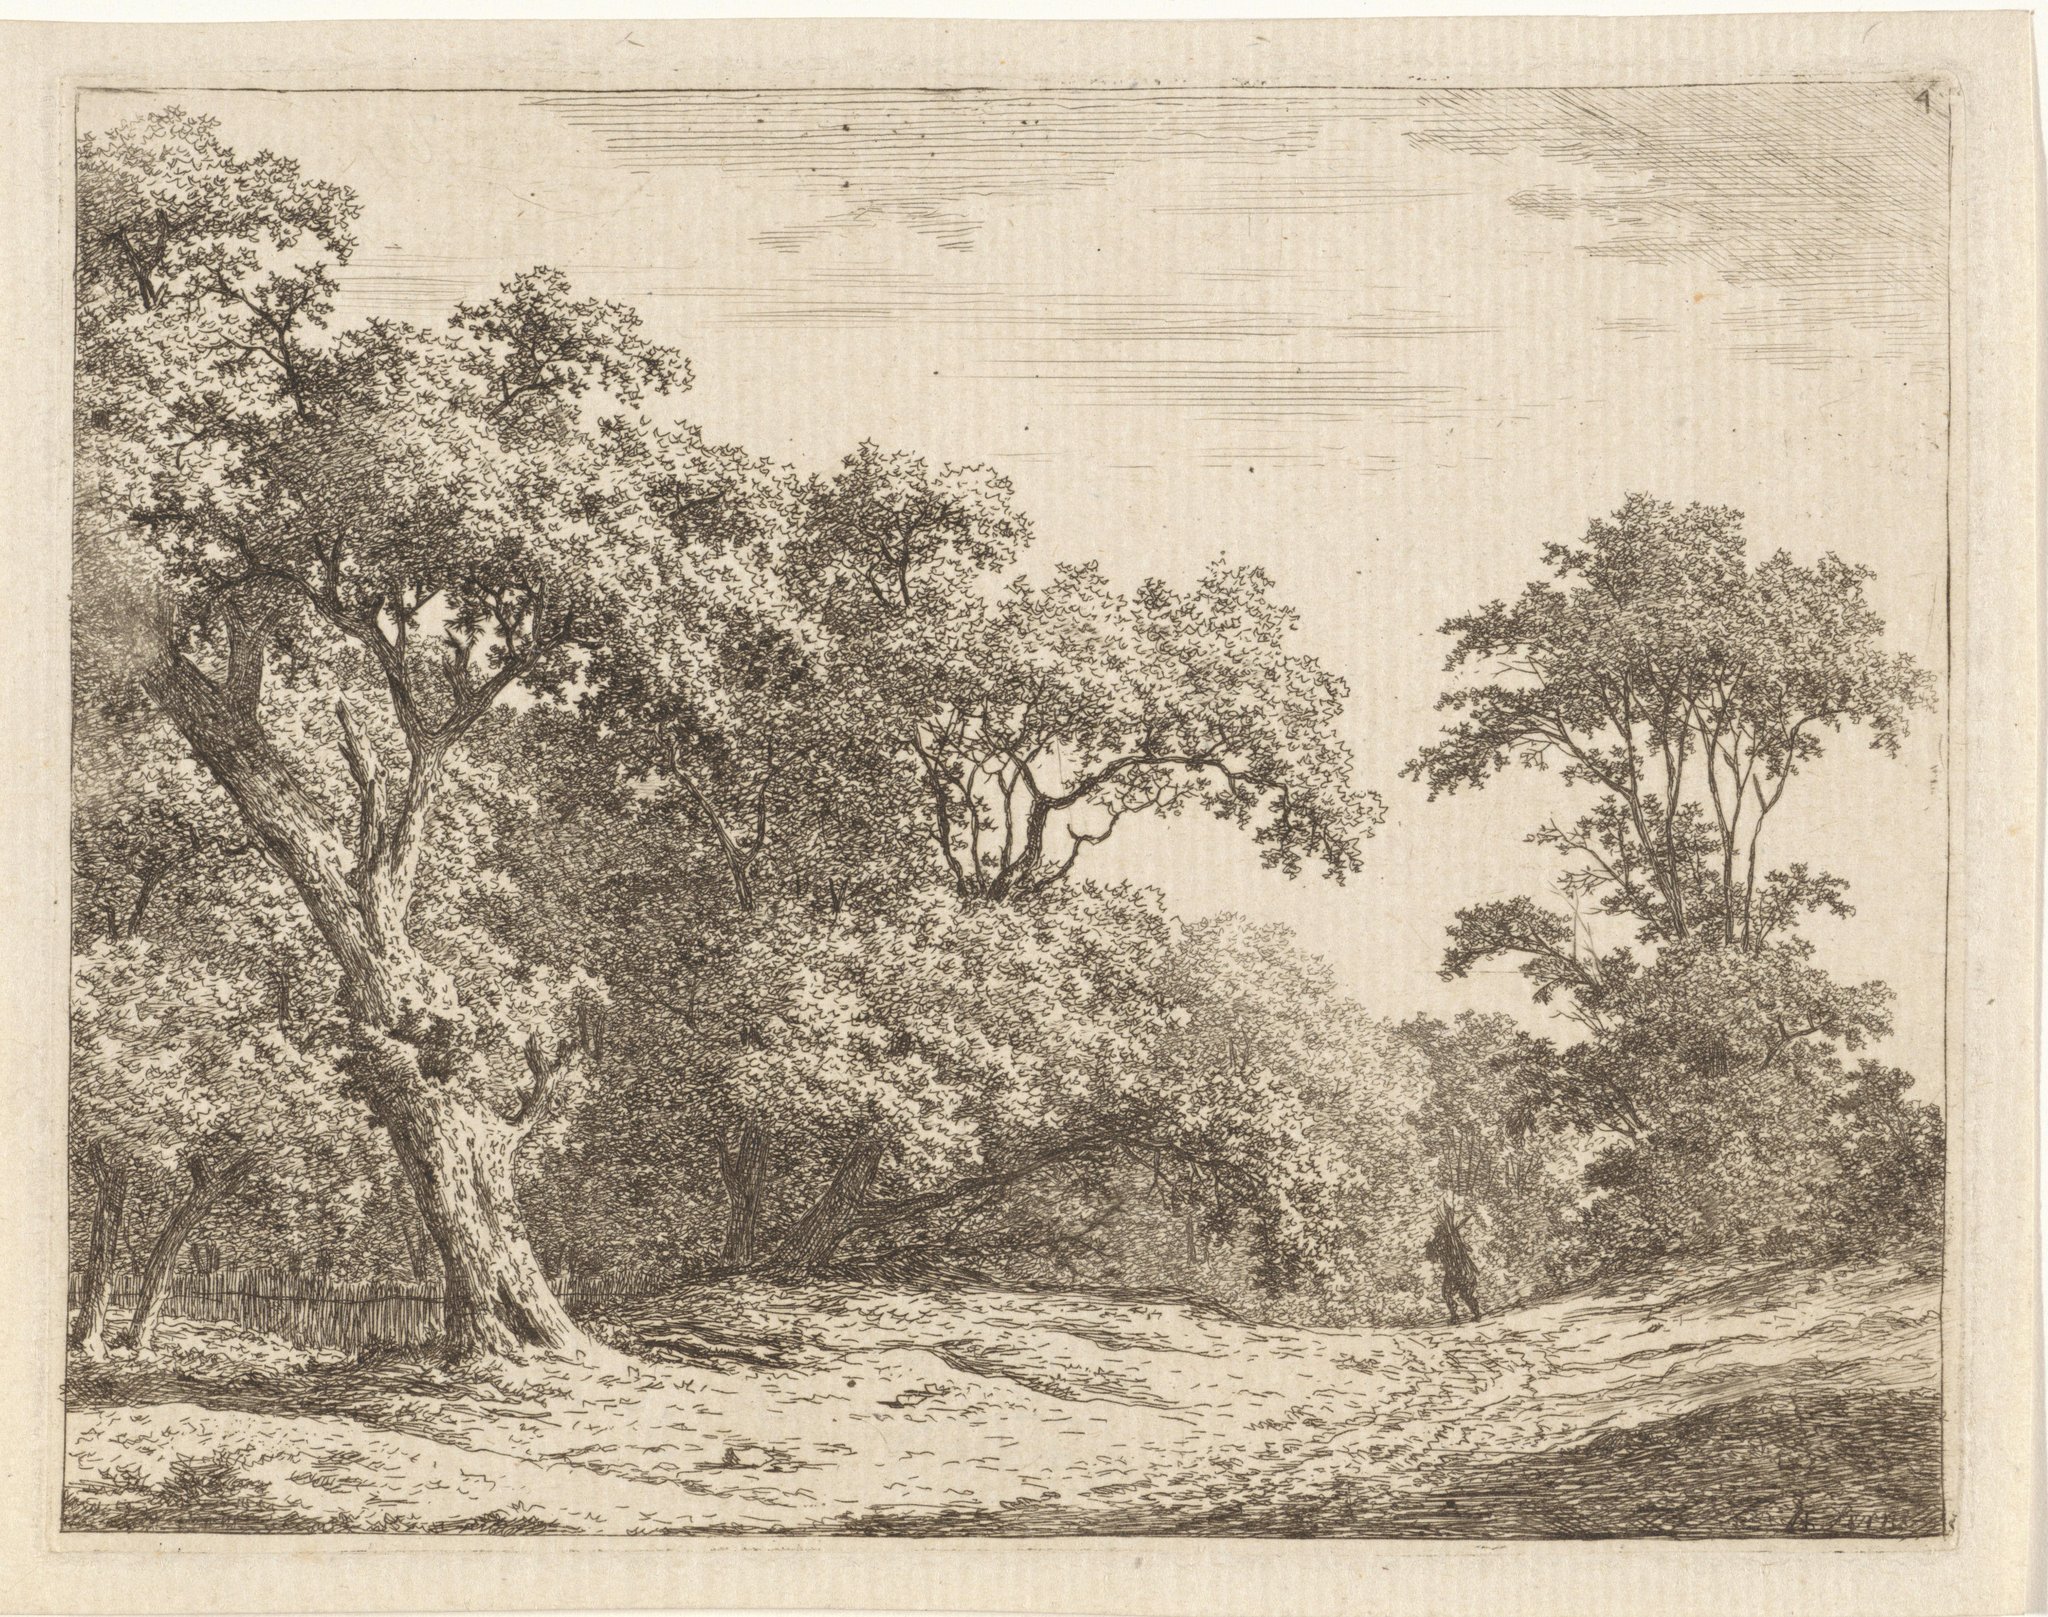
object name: print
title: Landschap met bomen en een man op weg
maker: adrianus serné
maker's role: print maker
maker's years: 1773-1853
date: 1783-1853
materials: paper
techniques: etching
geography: netherlands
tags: road, path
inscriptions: collector's mark: Lugt 2228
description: Landschap met bomen en een man op de weg. Rechtsboven genummerd: 4.